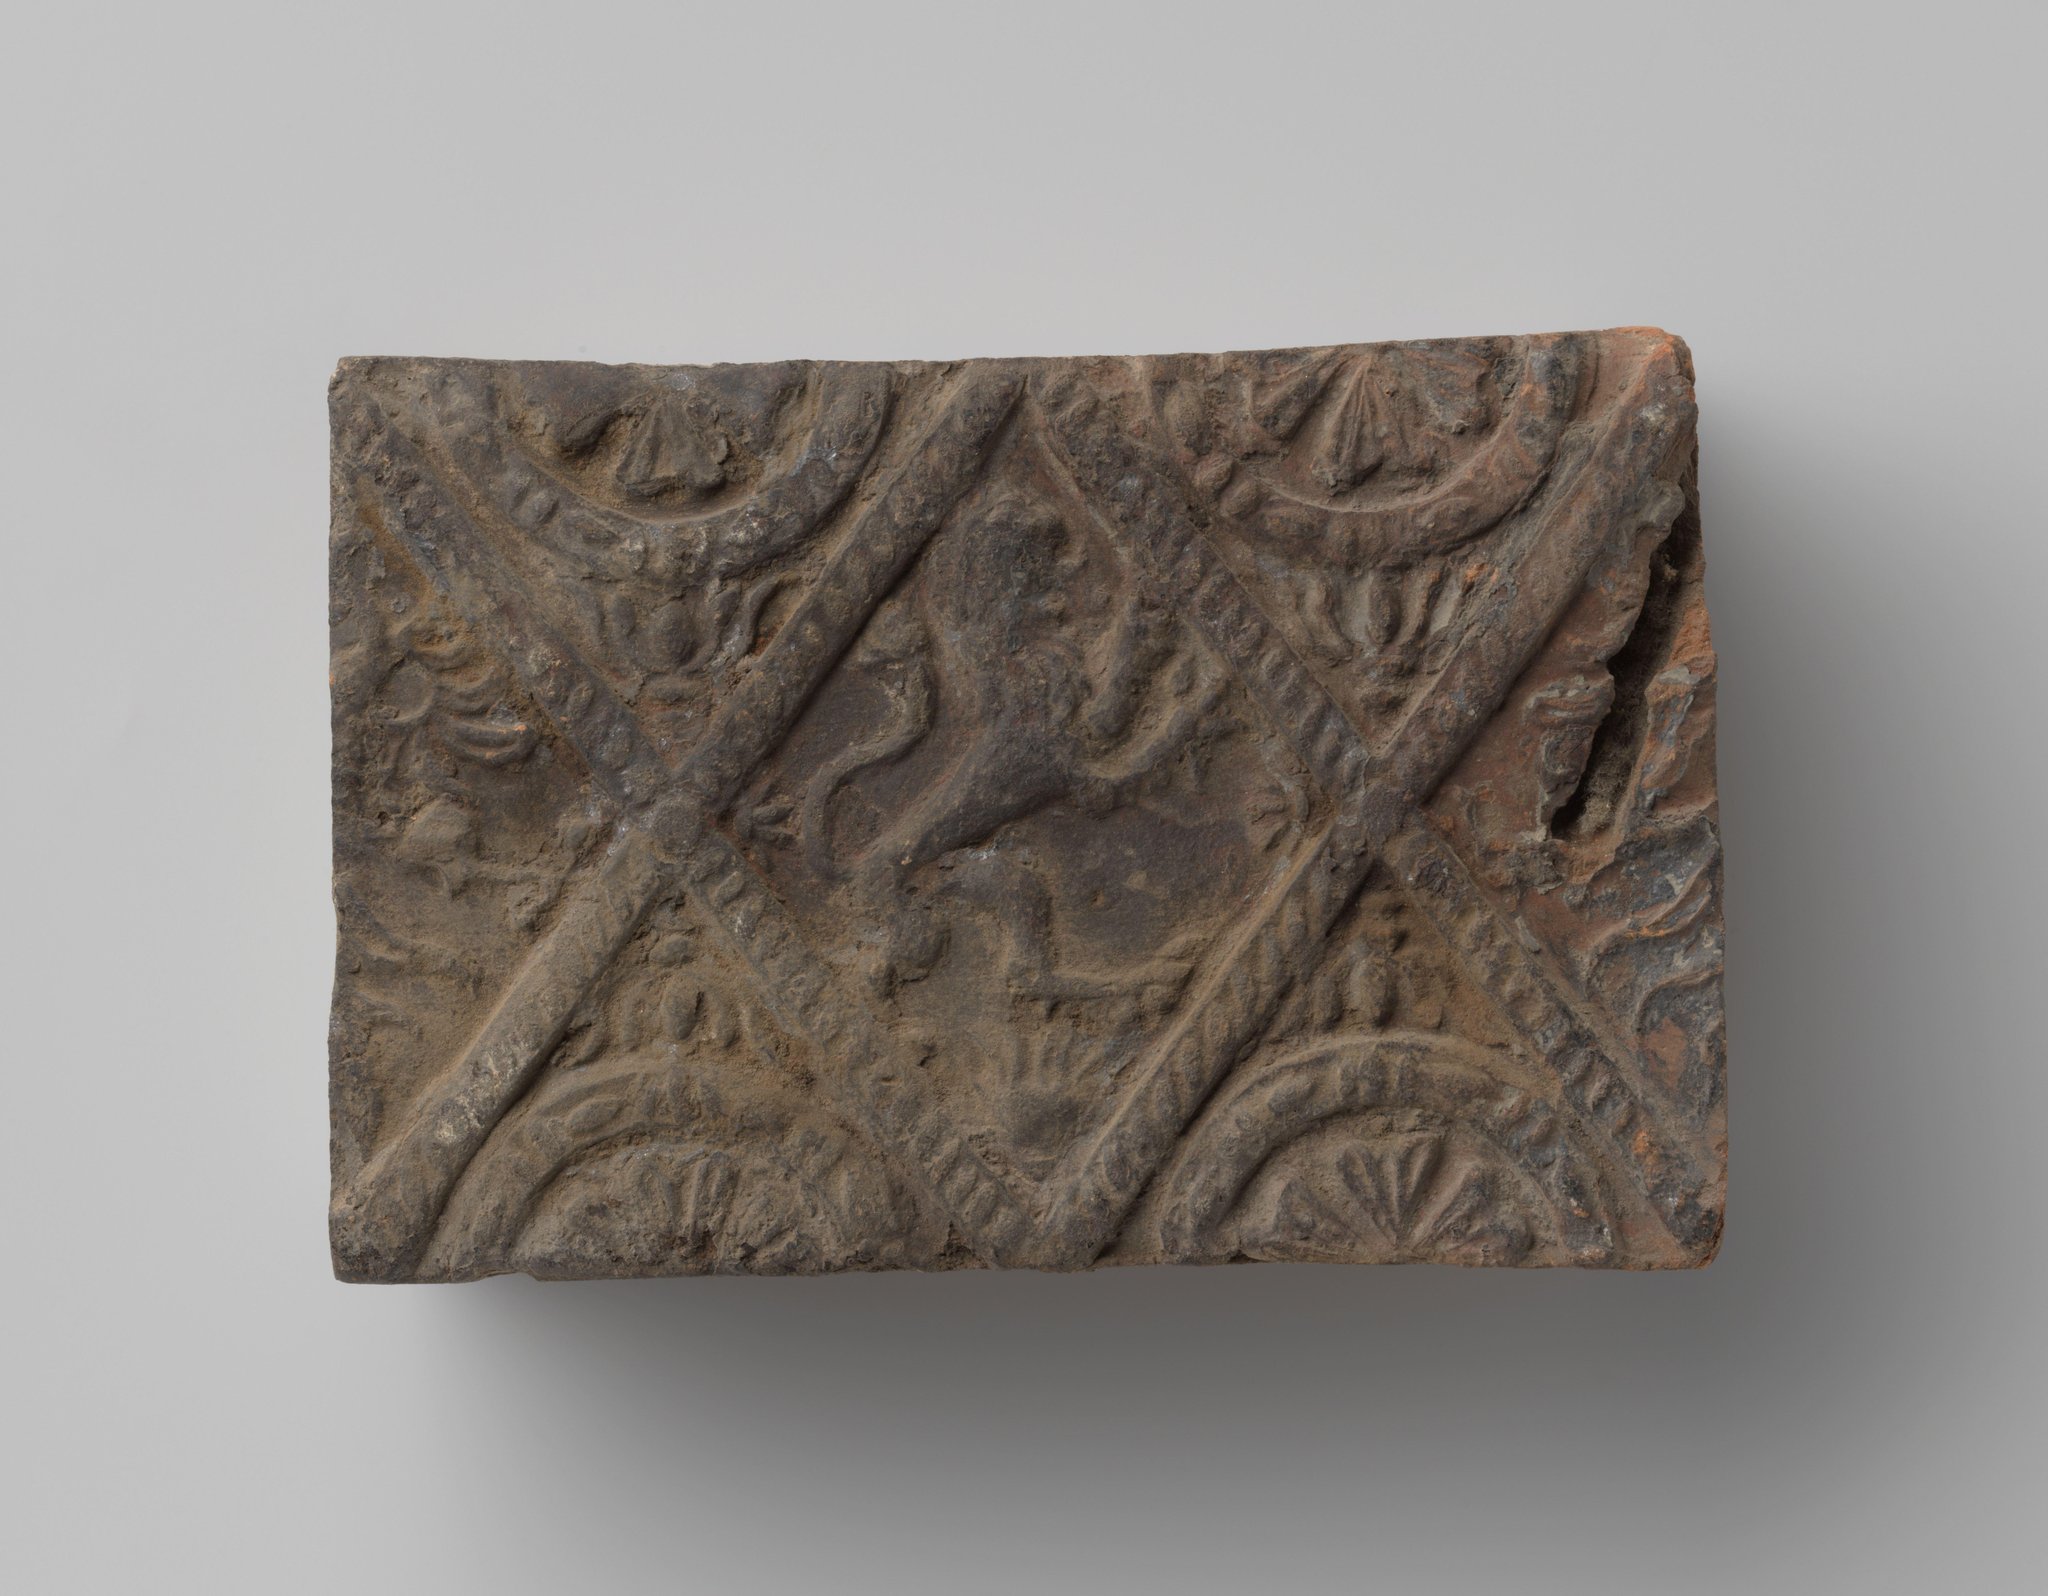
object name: hearthstone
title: Haardsteen met voorstelling van klimmende leeuw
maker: Anonymous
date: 1575-1625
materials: earthenware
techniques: printing, firing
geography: southern netherlands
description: Haardsteen met voorstelling van klimmende leeuw naar links (heraldisch) , geplaatst in geprofileerde ruit. In de halve ruiten aan de zijkanten een dubbelkoppige adelaar. De halve ruiten aan de boven- en onderkant zijn opgevuld met halve medaillons met stermotief.